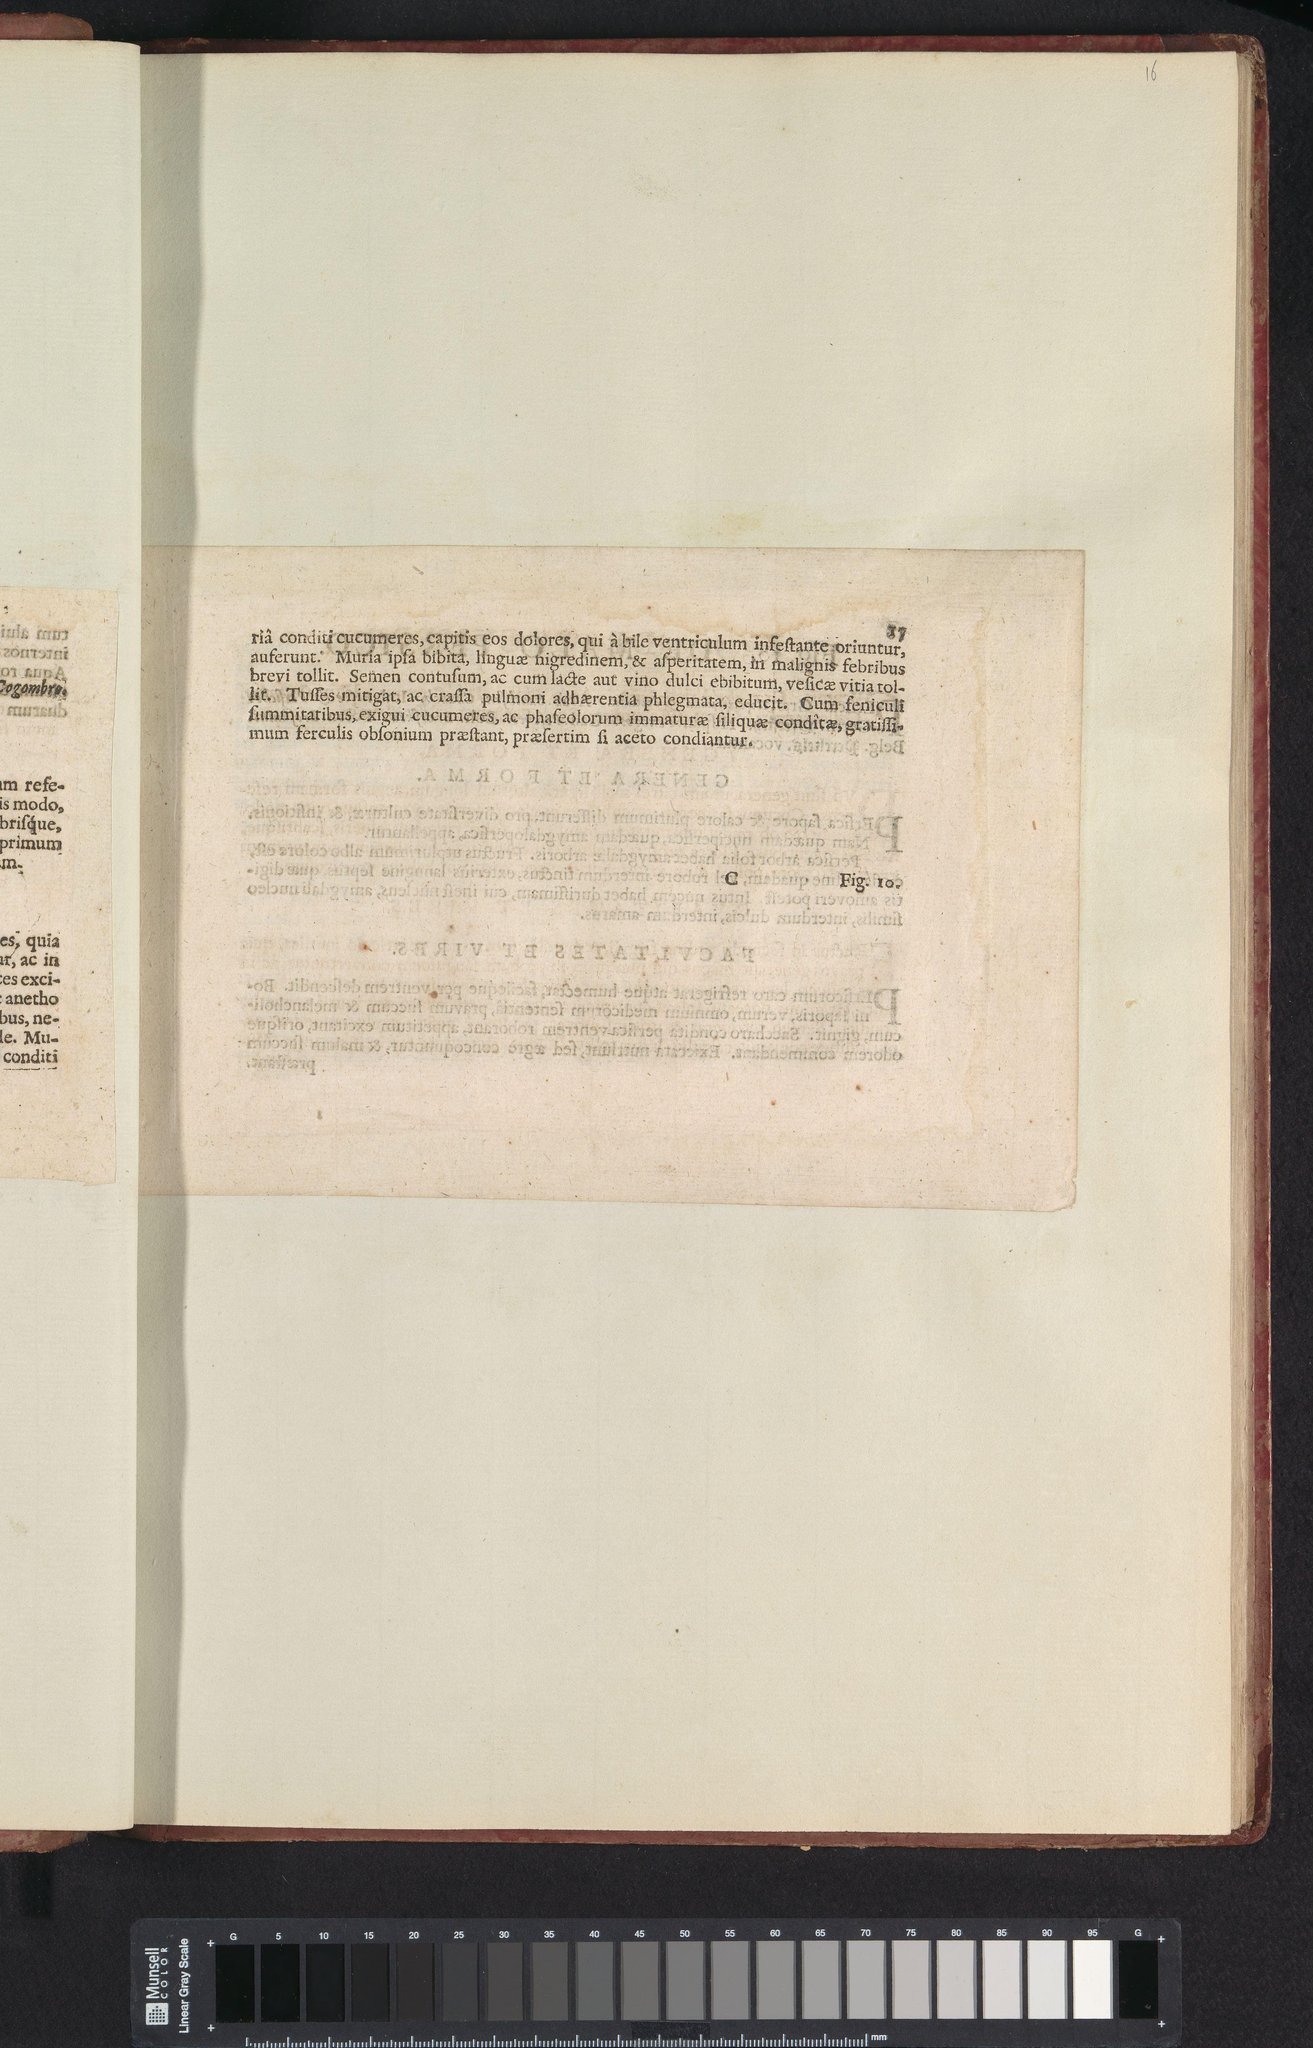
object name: text sheet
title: Fig. 9 'De Cvcvmere' in De Boodts herbarium van 1640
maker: anselmus boëtius de boodt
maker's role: draughtsman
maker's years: 1550-1632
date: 1640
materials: ink, paper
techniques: letterpress printing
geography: bruges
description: Beschrijving bij Fig. 9 op p. 17 in: Anselmi Boëtii de Boot I.C. Brugensis & Rodolphi II. Imp. Roman. medici a cubiculis Florum, Herbarum, ac fructuum selectiorum icones, & vires pleraeque hactenus ignotæ. Onderdeel van het album met bladen en platen uit De Boodts herbarium van 1640. Het twaalfde van twaalf albums met aquarellen van dieren, vogels en planten bekend rond 1600, gemaakt in opdracht van keizer Rudolf II.